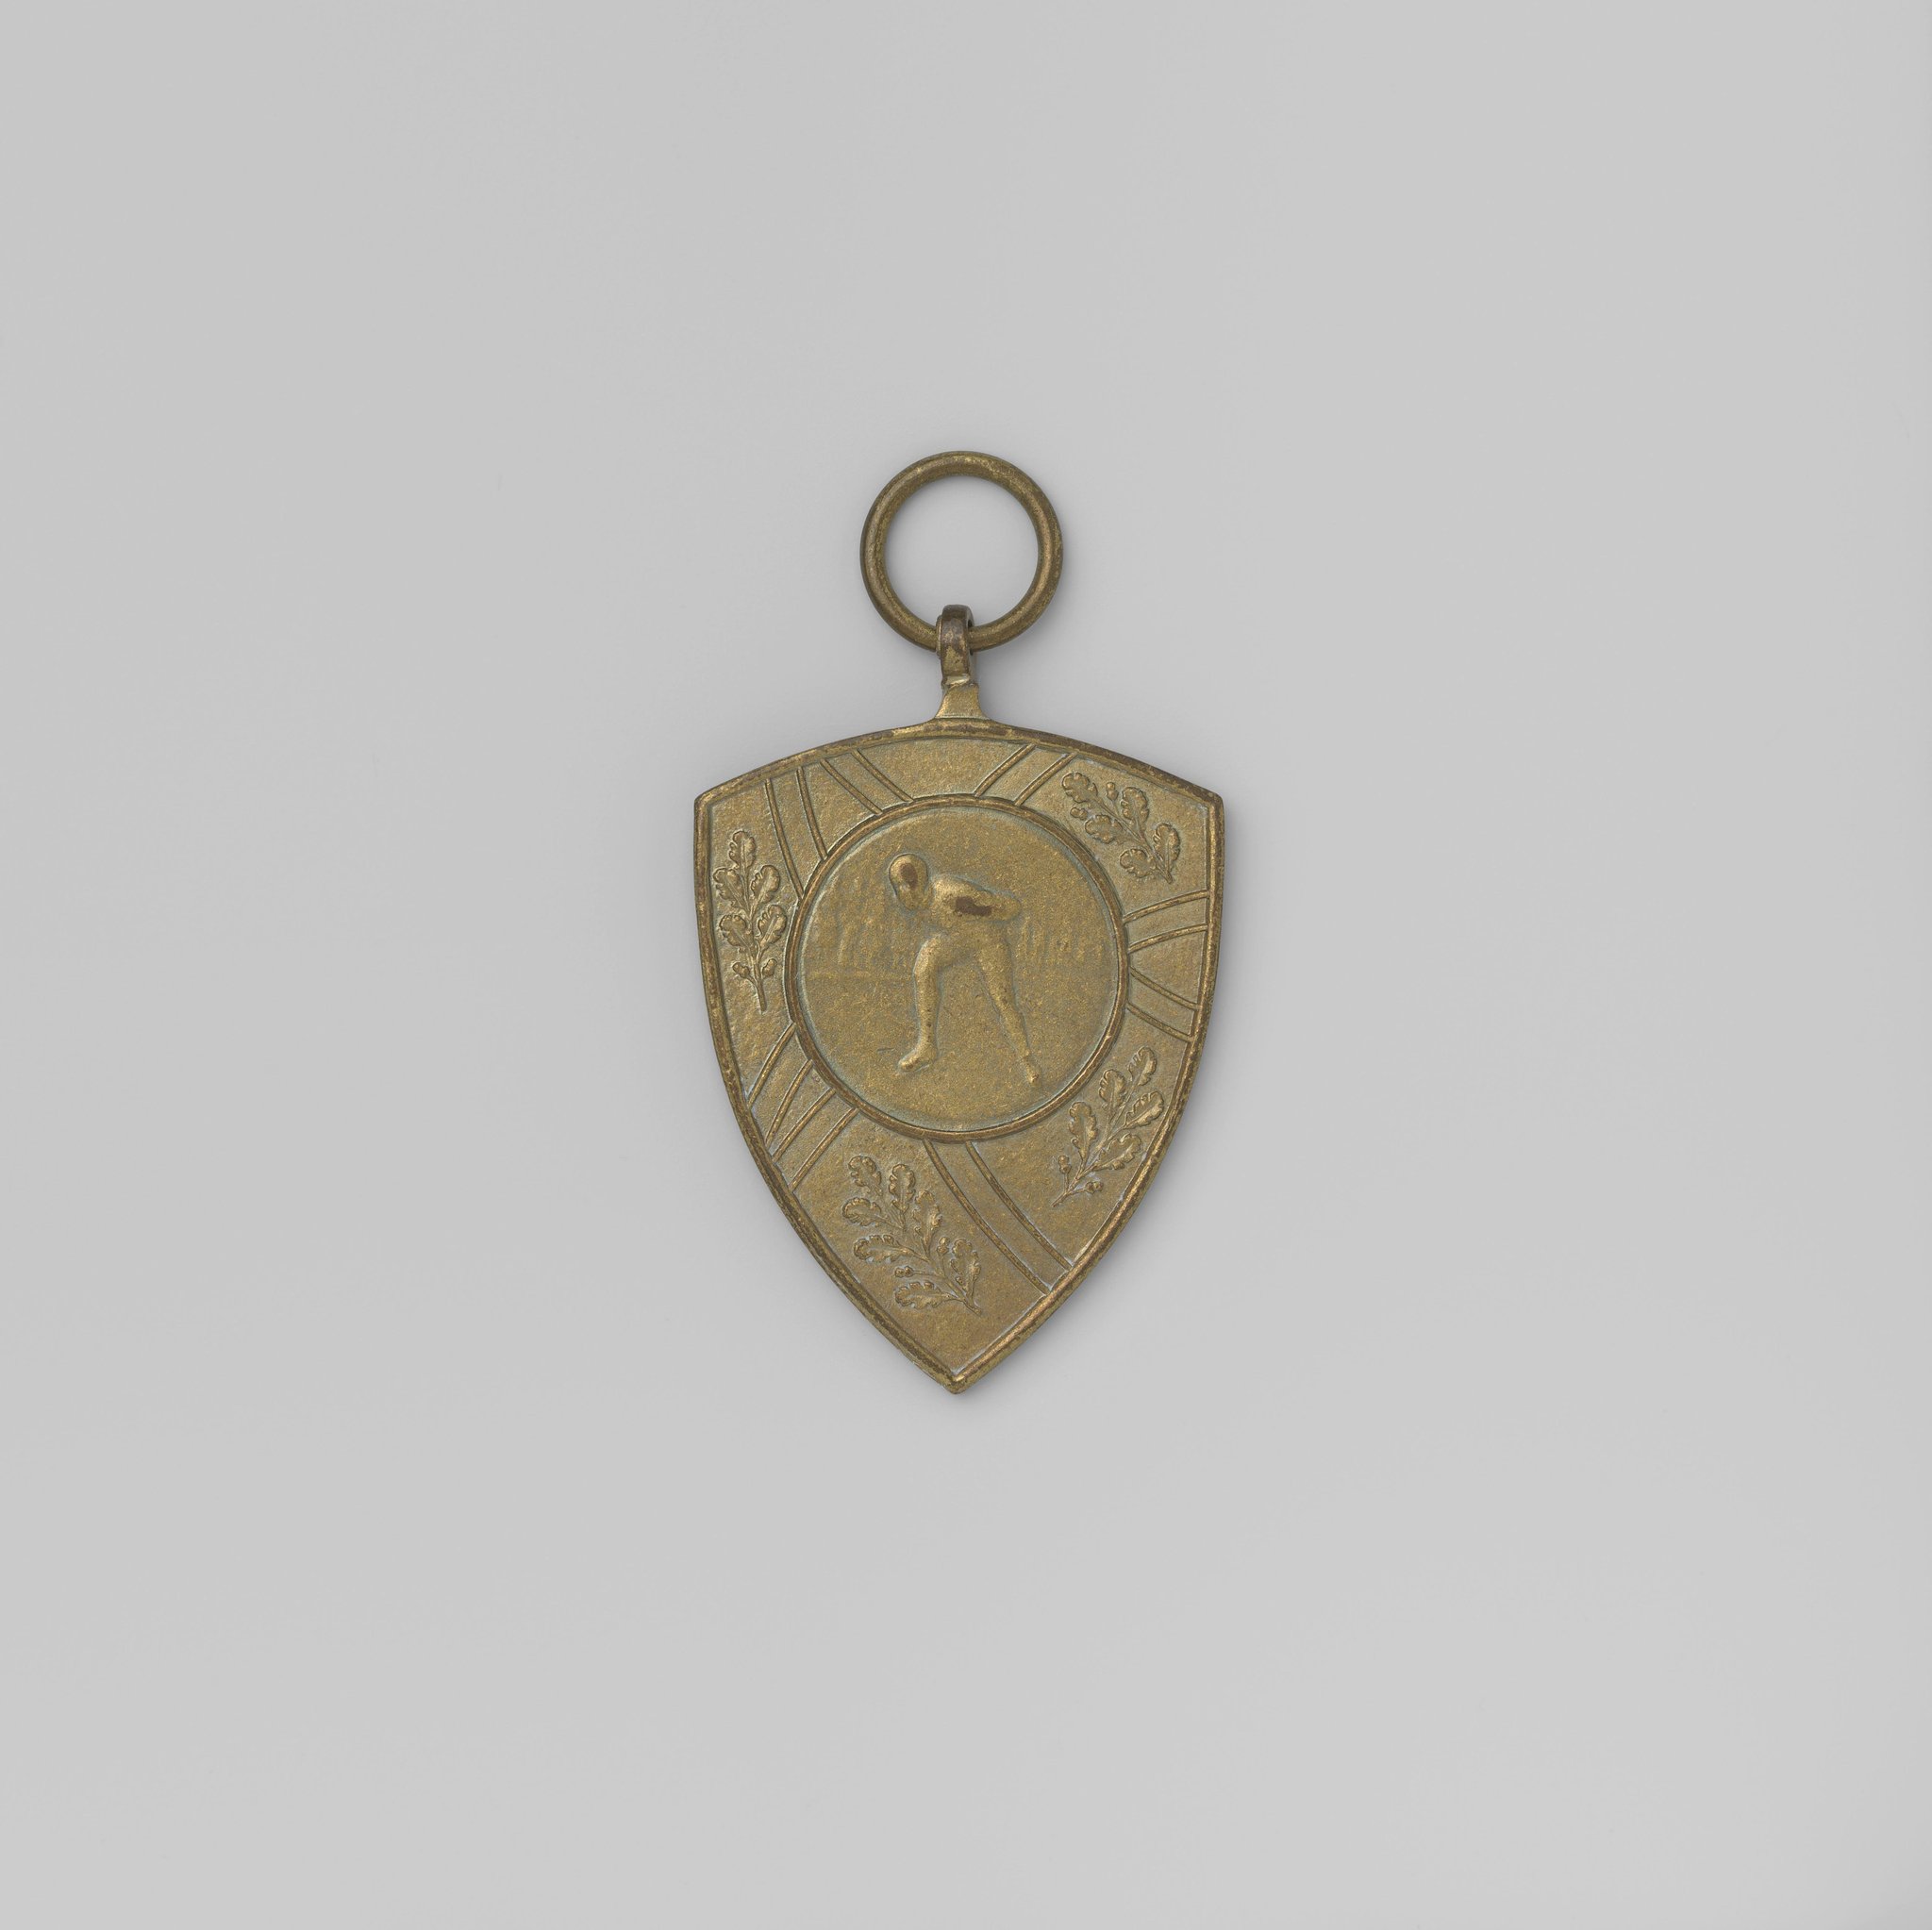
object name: onderscheidingsteken, onderscheiding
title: Onderscheiding 16 Dorpentocht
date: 1950-2000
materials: metal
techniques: striking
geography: sneek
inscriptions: inscription: ‘16 Dorpentocht 80 km’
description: Schildvormige onderscheiding, met draagoog en ringetje, met in ronde cirkel schaatser, waaromheen vier lauriertakken en 7 banden; keerzijde: opschrift ‘16 Dorpentocht 80 km’.